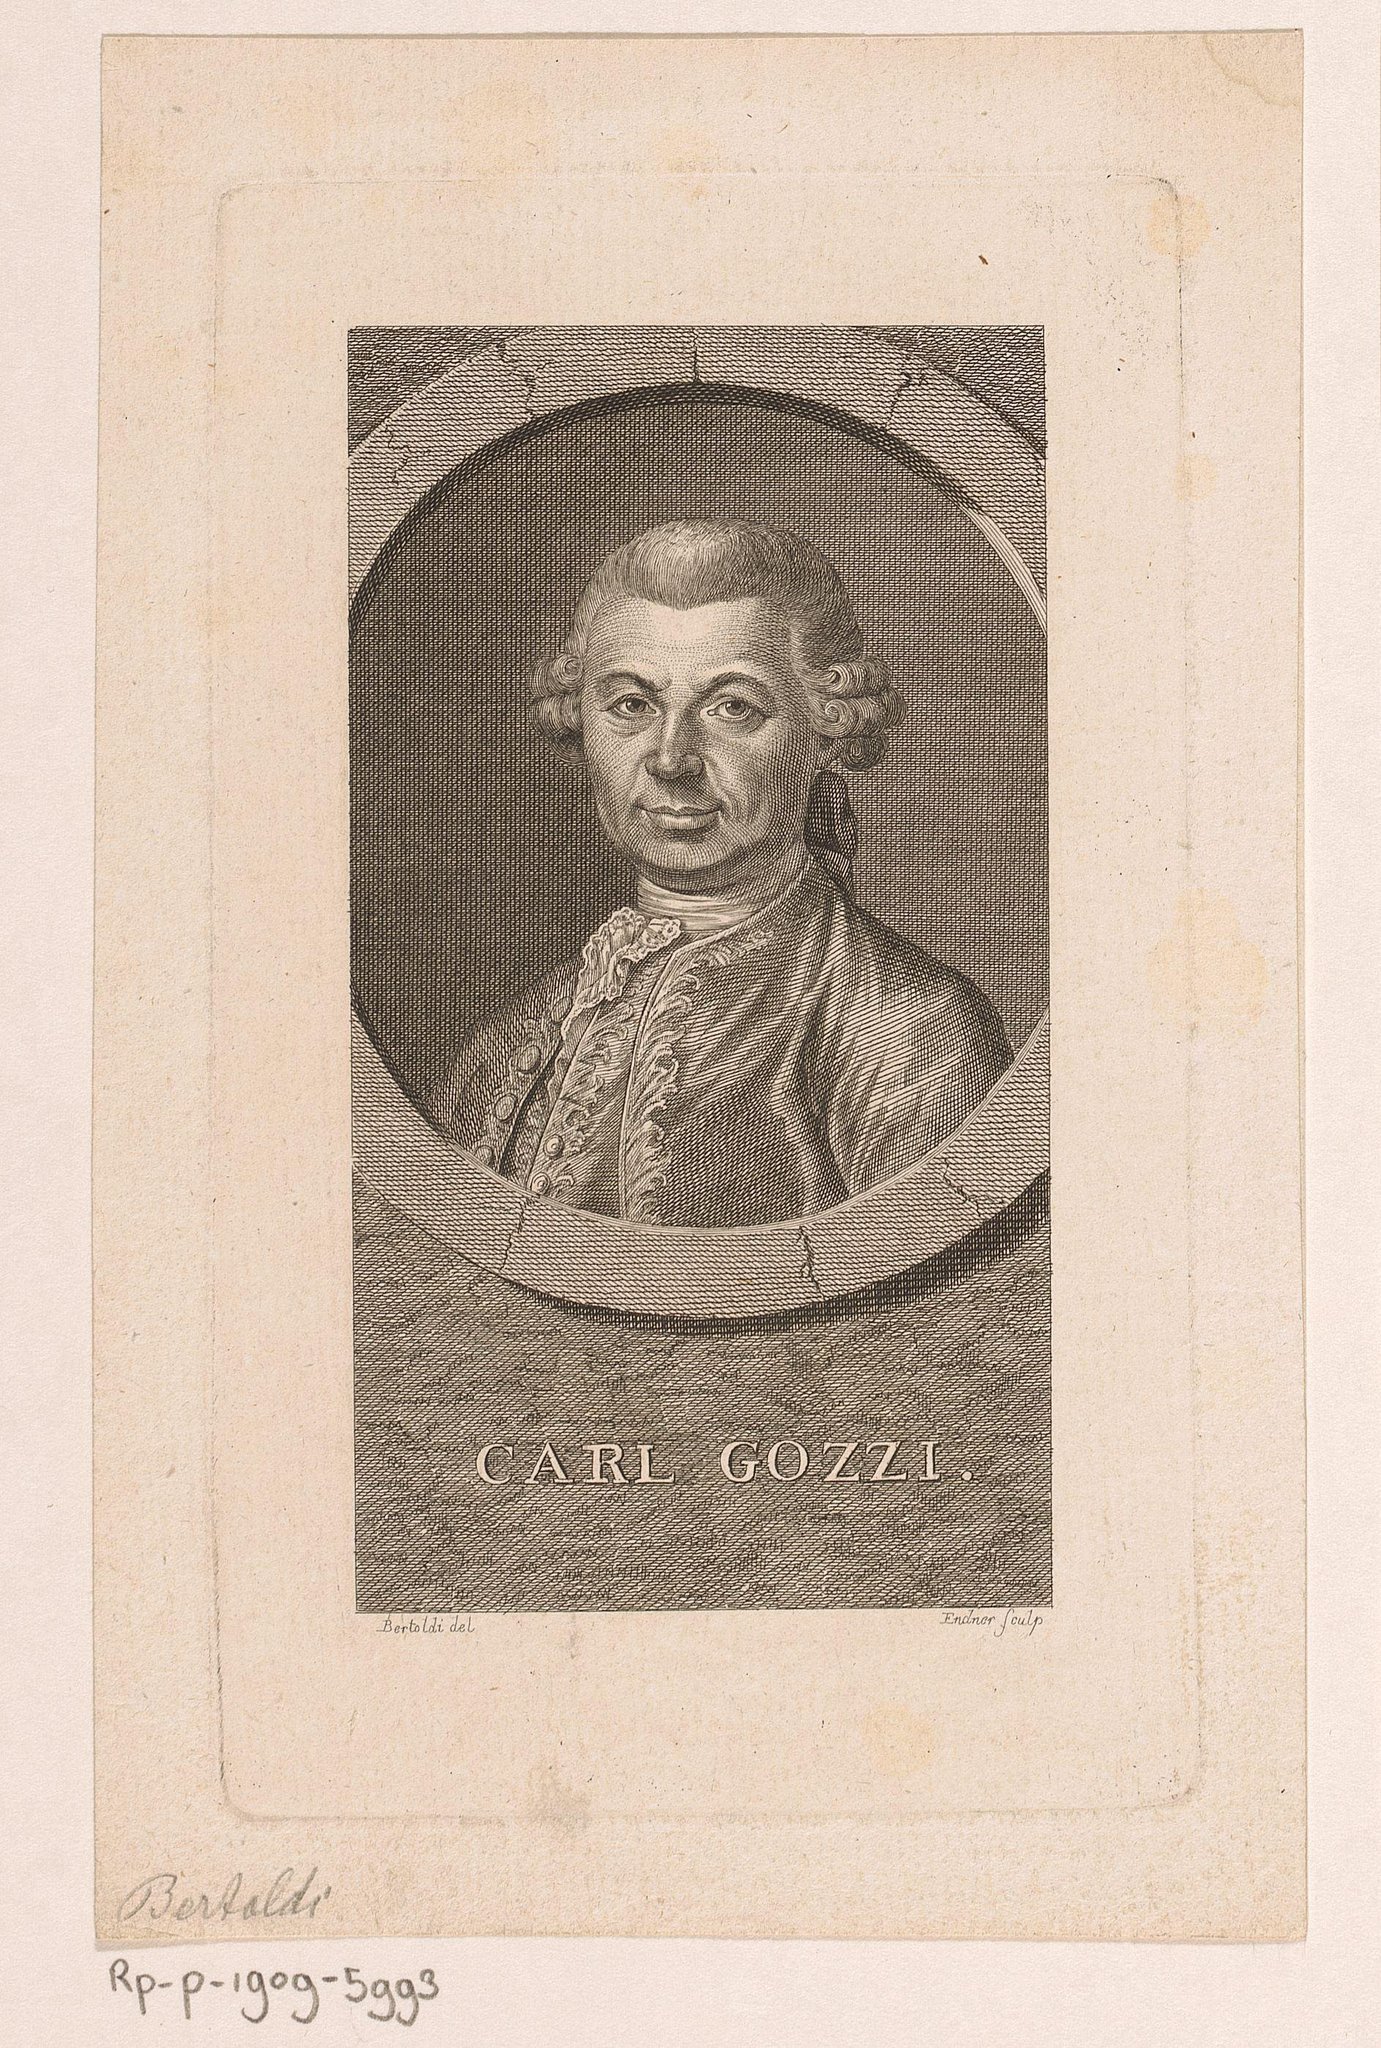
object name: print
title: Portret van Carlo Gozzi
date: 1764-1824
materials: paper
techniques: engraving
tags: historical persons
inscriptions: collector's mark: Lugt 2228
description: Prent gebruikt voor: Neue Bibliothek der schönen Wissenschaften und der freyen Künste. Leipzig: Dyckischen Buchhandlung, 1783, dl. 28.